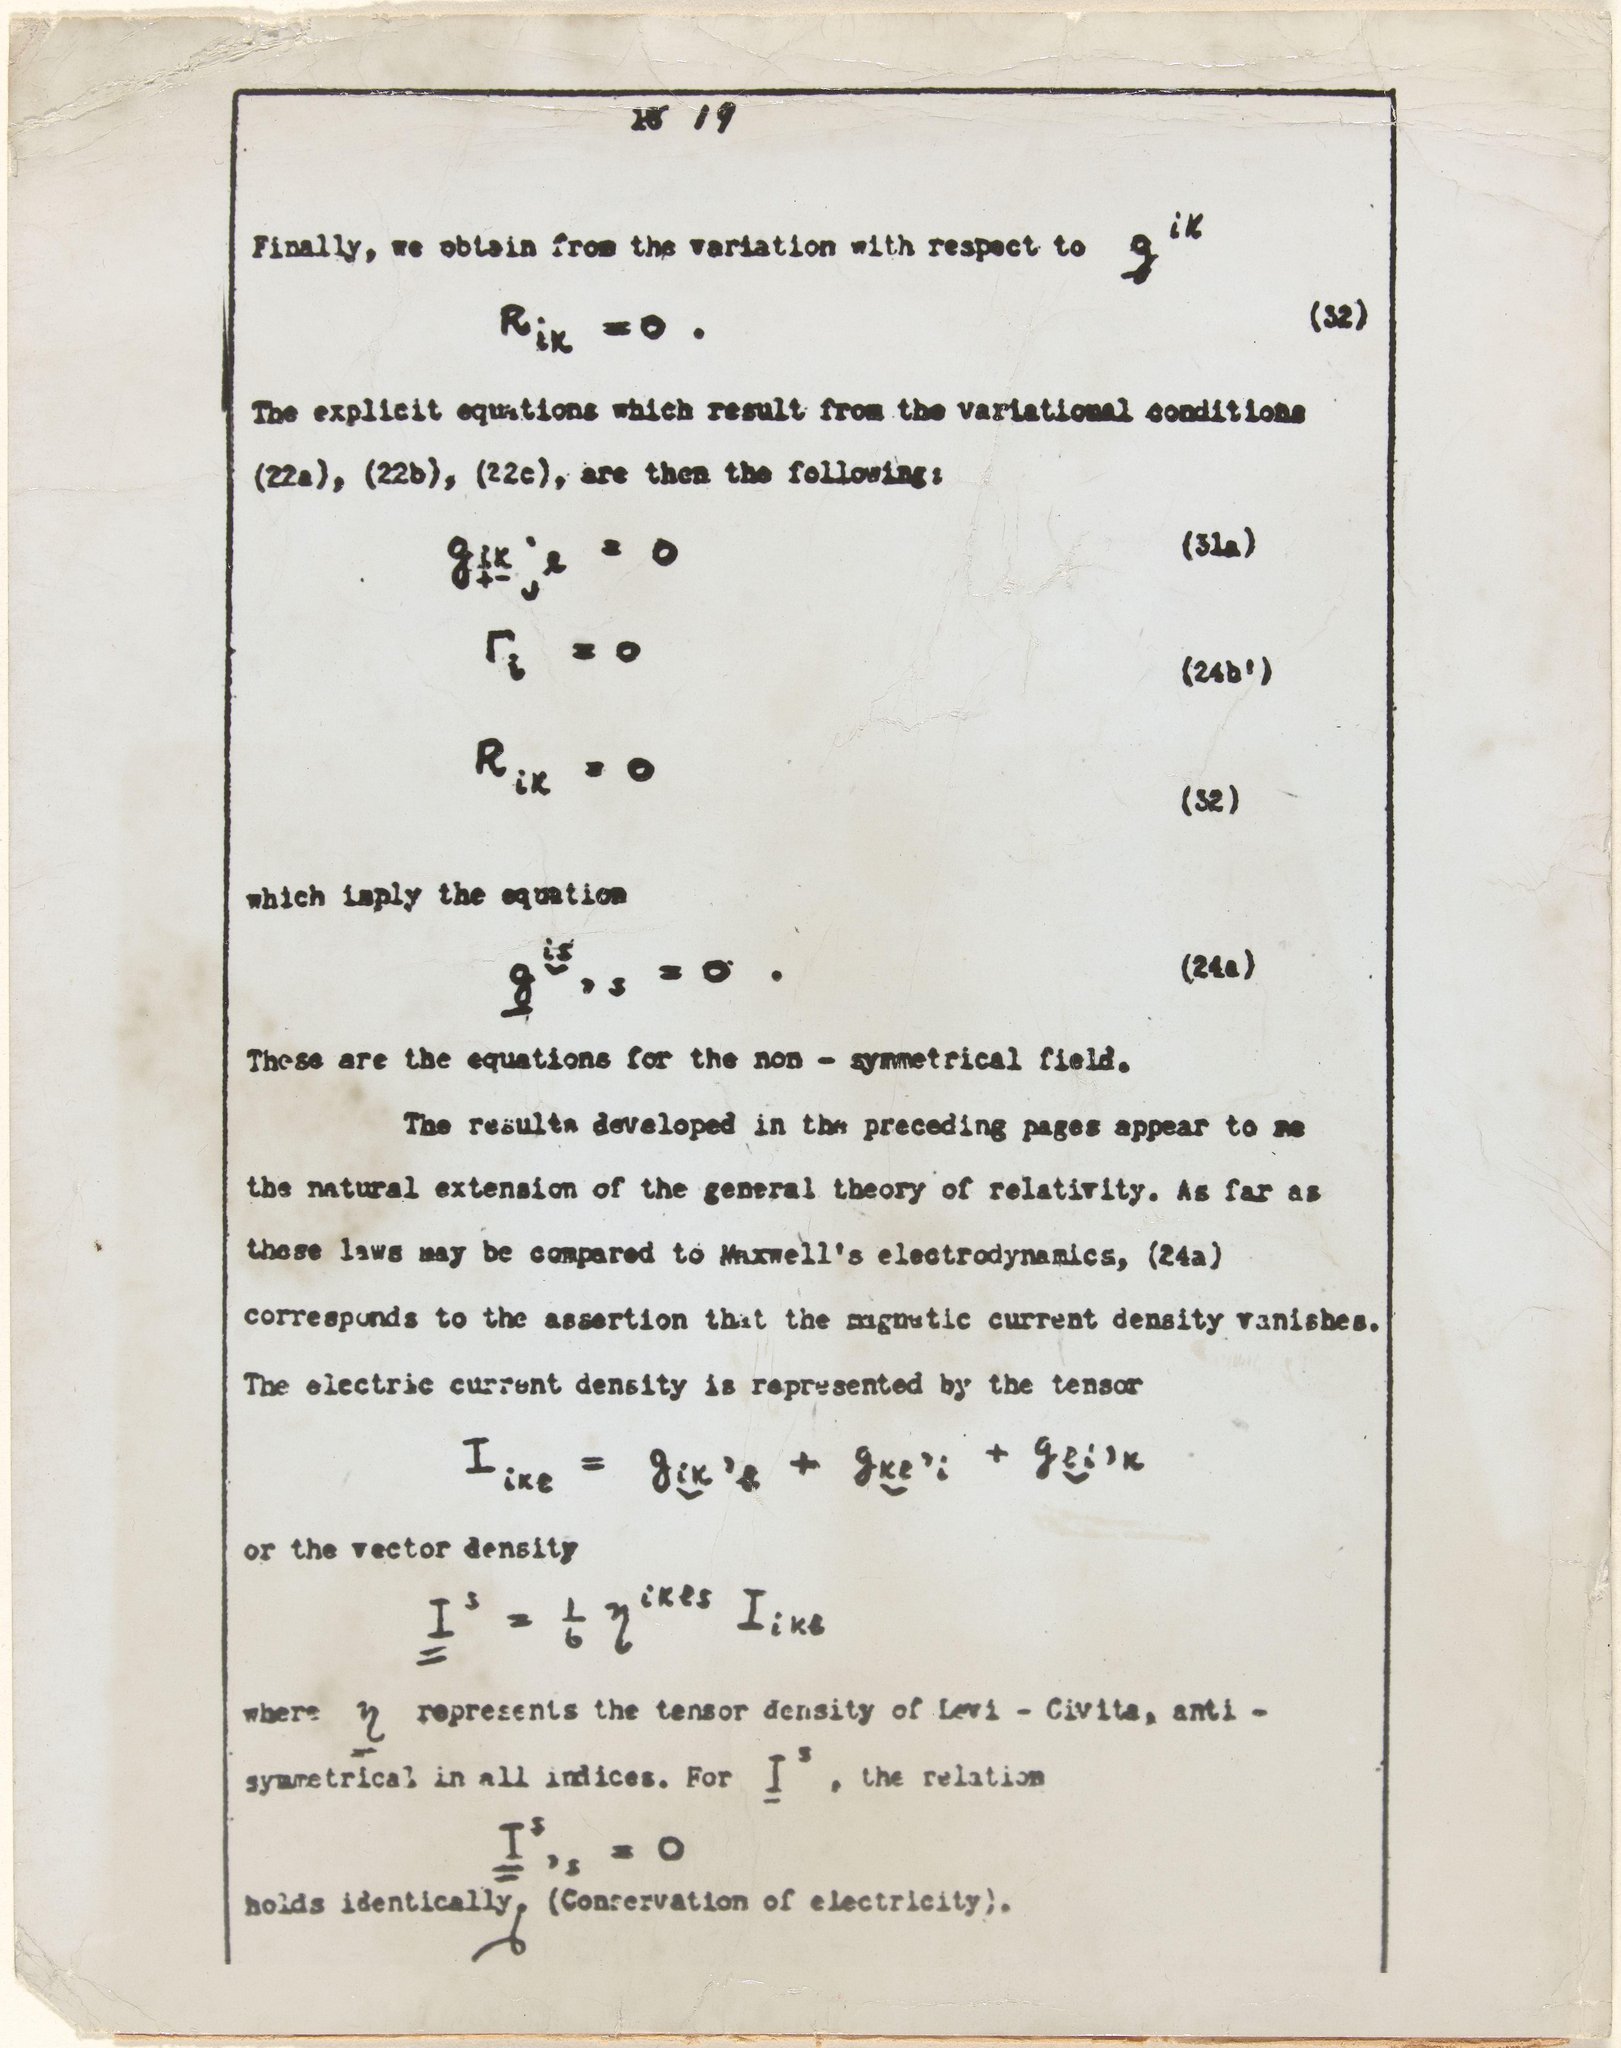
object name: photograph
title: Einsteins master key to the universe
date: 1949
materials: photographic support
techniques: gelatin silver print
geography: new york city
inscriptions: stamp: ‘international new photos’